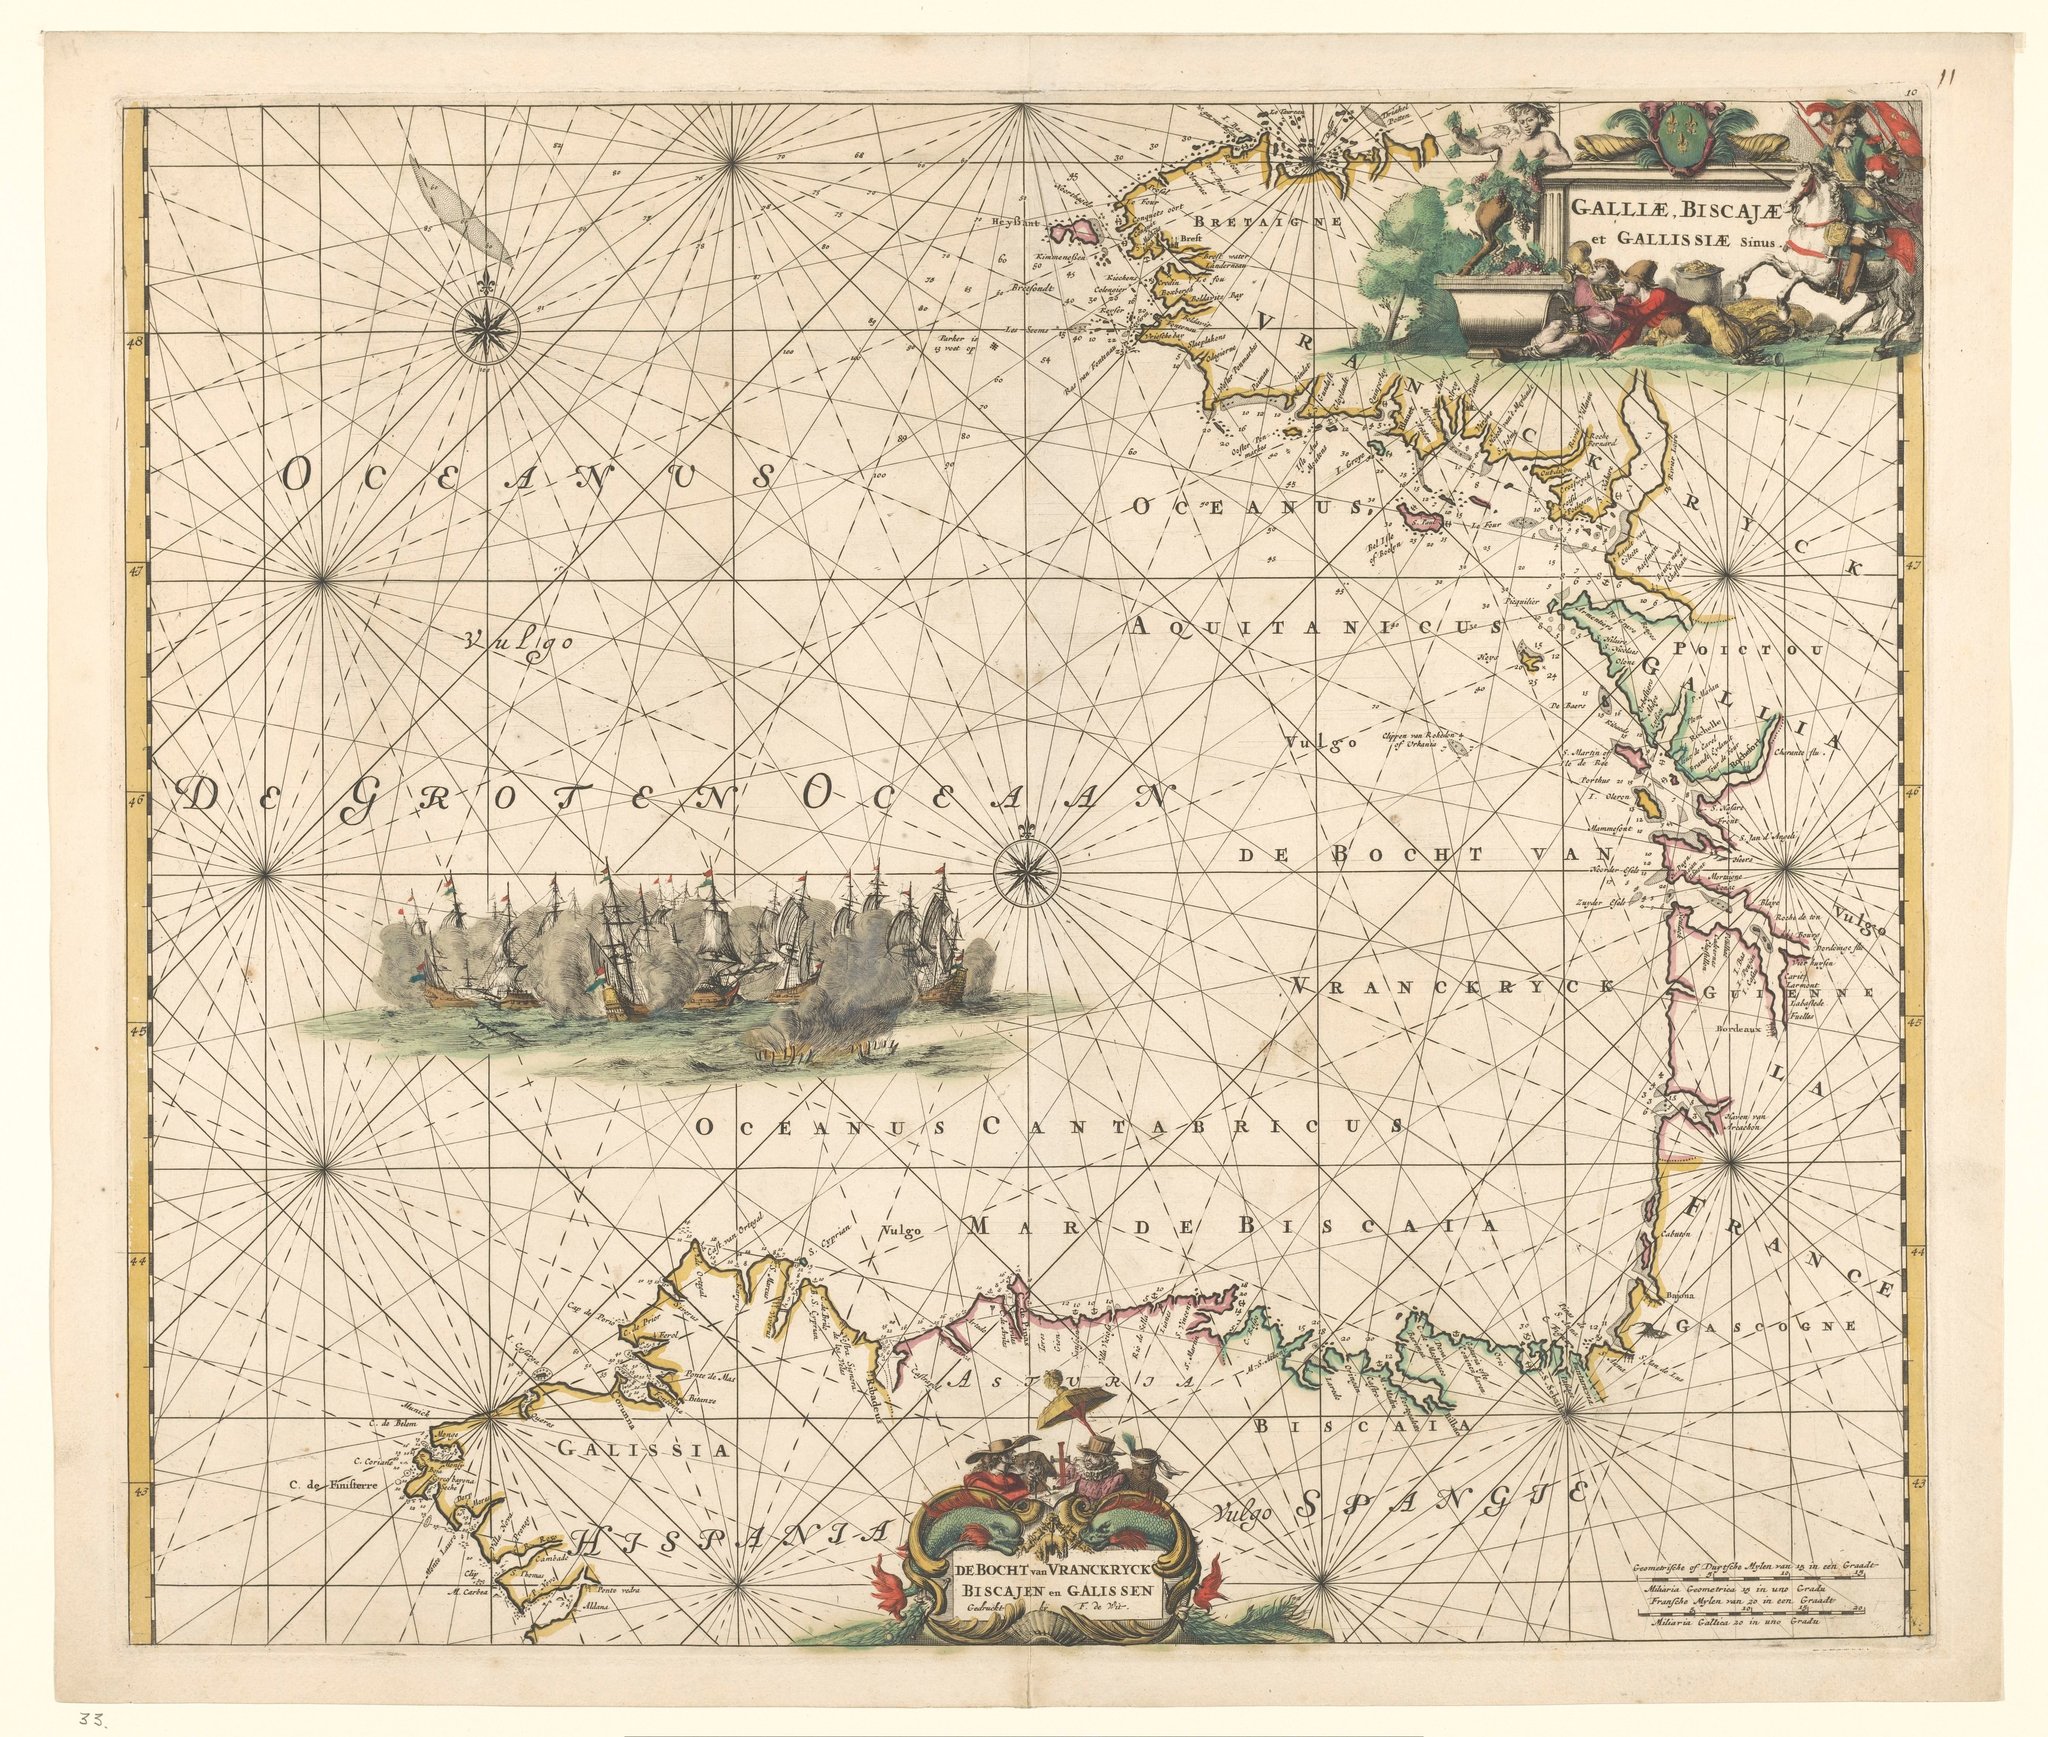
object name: print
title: Zeekaart van de Golf van Biskaje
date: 1675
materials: paper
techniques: engraving, hand coloring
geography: netherlands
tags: marine charts, battle (+ naval force), france, spain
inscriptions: number: ‘10’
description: Zeekaart van de Golf van Biskaje, de Atlantische kust tussen Bretagne en het noordwesten van Spanje. In de zee twee kompasrozen en een zeeslag met Nederlandse schepen. Rechtsboven een cartouche met de Latijnse titel versierd met het Franse wapen, een ruiter, twee mannen die eten en drinken en een sater met druiventrossen. Middenonder een cartouche met de Nederlandse titel. Deze cartouche versierd met vissen, het Gulden Vlies en verschillende Spanjaarden. Rechtsonder twee schaalstokken in Duitse en Franse mijlen. Genummerd rechtsboven: 10.